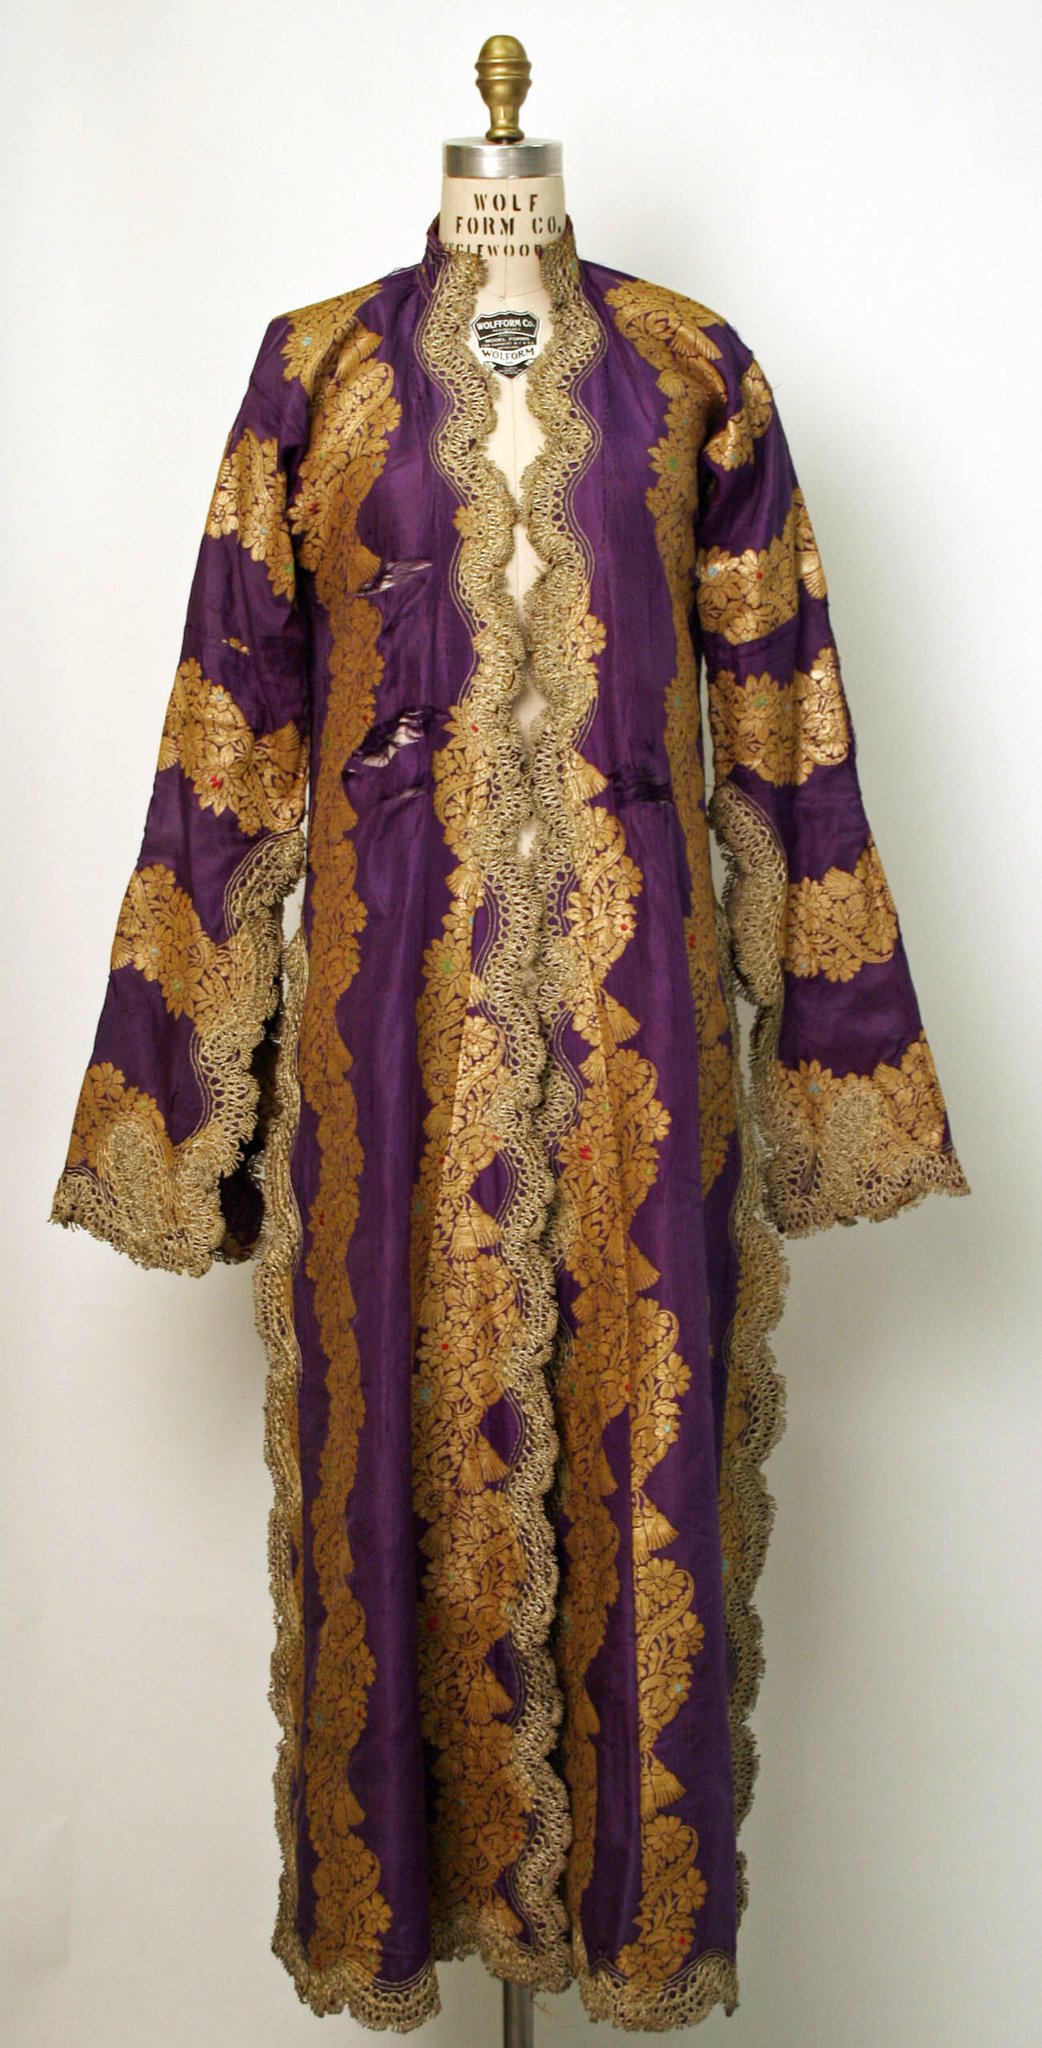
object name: ensemble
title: Uçetek Entari and Shalvar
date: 1867-1900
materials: cotton, metal thread, silk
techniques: brocade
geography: turkey